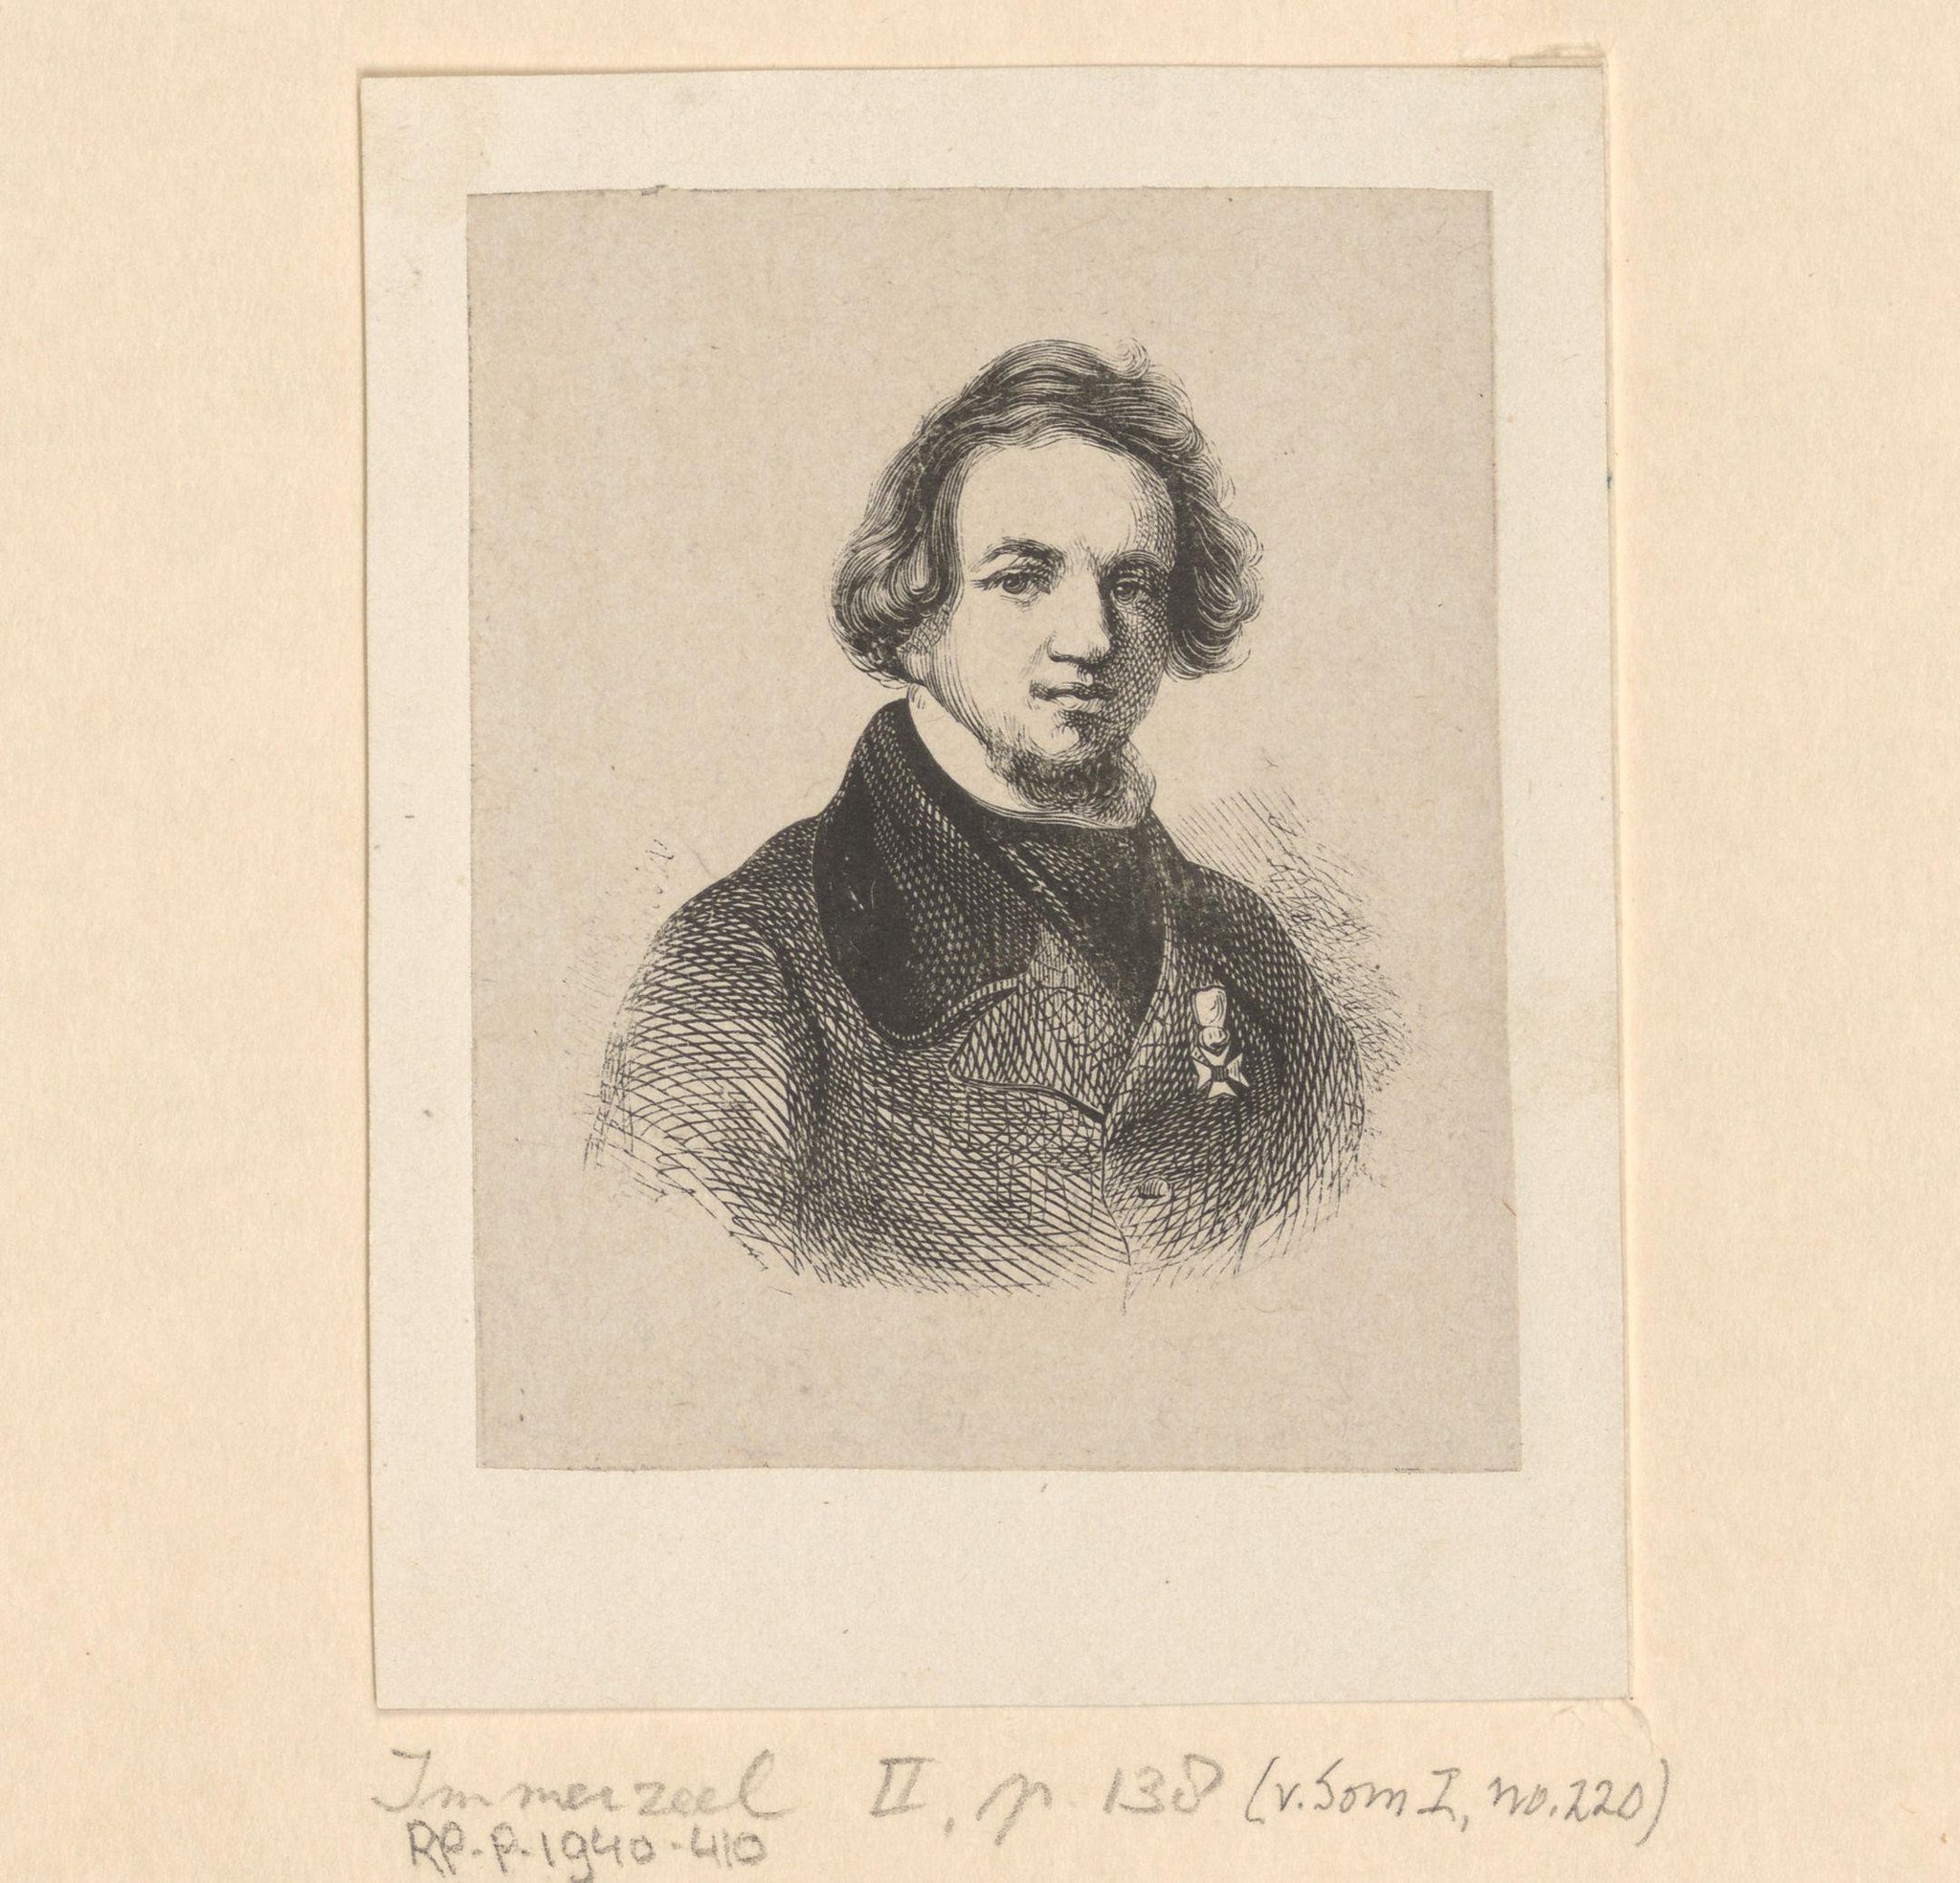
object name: print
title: Portret van Cornelis Kruseman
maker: Anonymous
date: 1842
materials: paper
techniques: engraving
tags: amsterdam, draughtsman, cornelis kruseman, historical persons, portrait, self-portrait of painter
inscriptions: collector's mark: Lugt 2760, collector's mark: Lugt 2228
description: Prent met tekst op verso gebruikt in: Immerzeel, Johannes. De levens en werken der Hollandsche en Vlaamsche kunstschilders. Den Haag: Johannes Christoffel van Kesteren, 1842, dl. 1, p. 138.